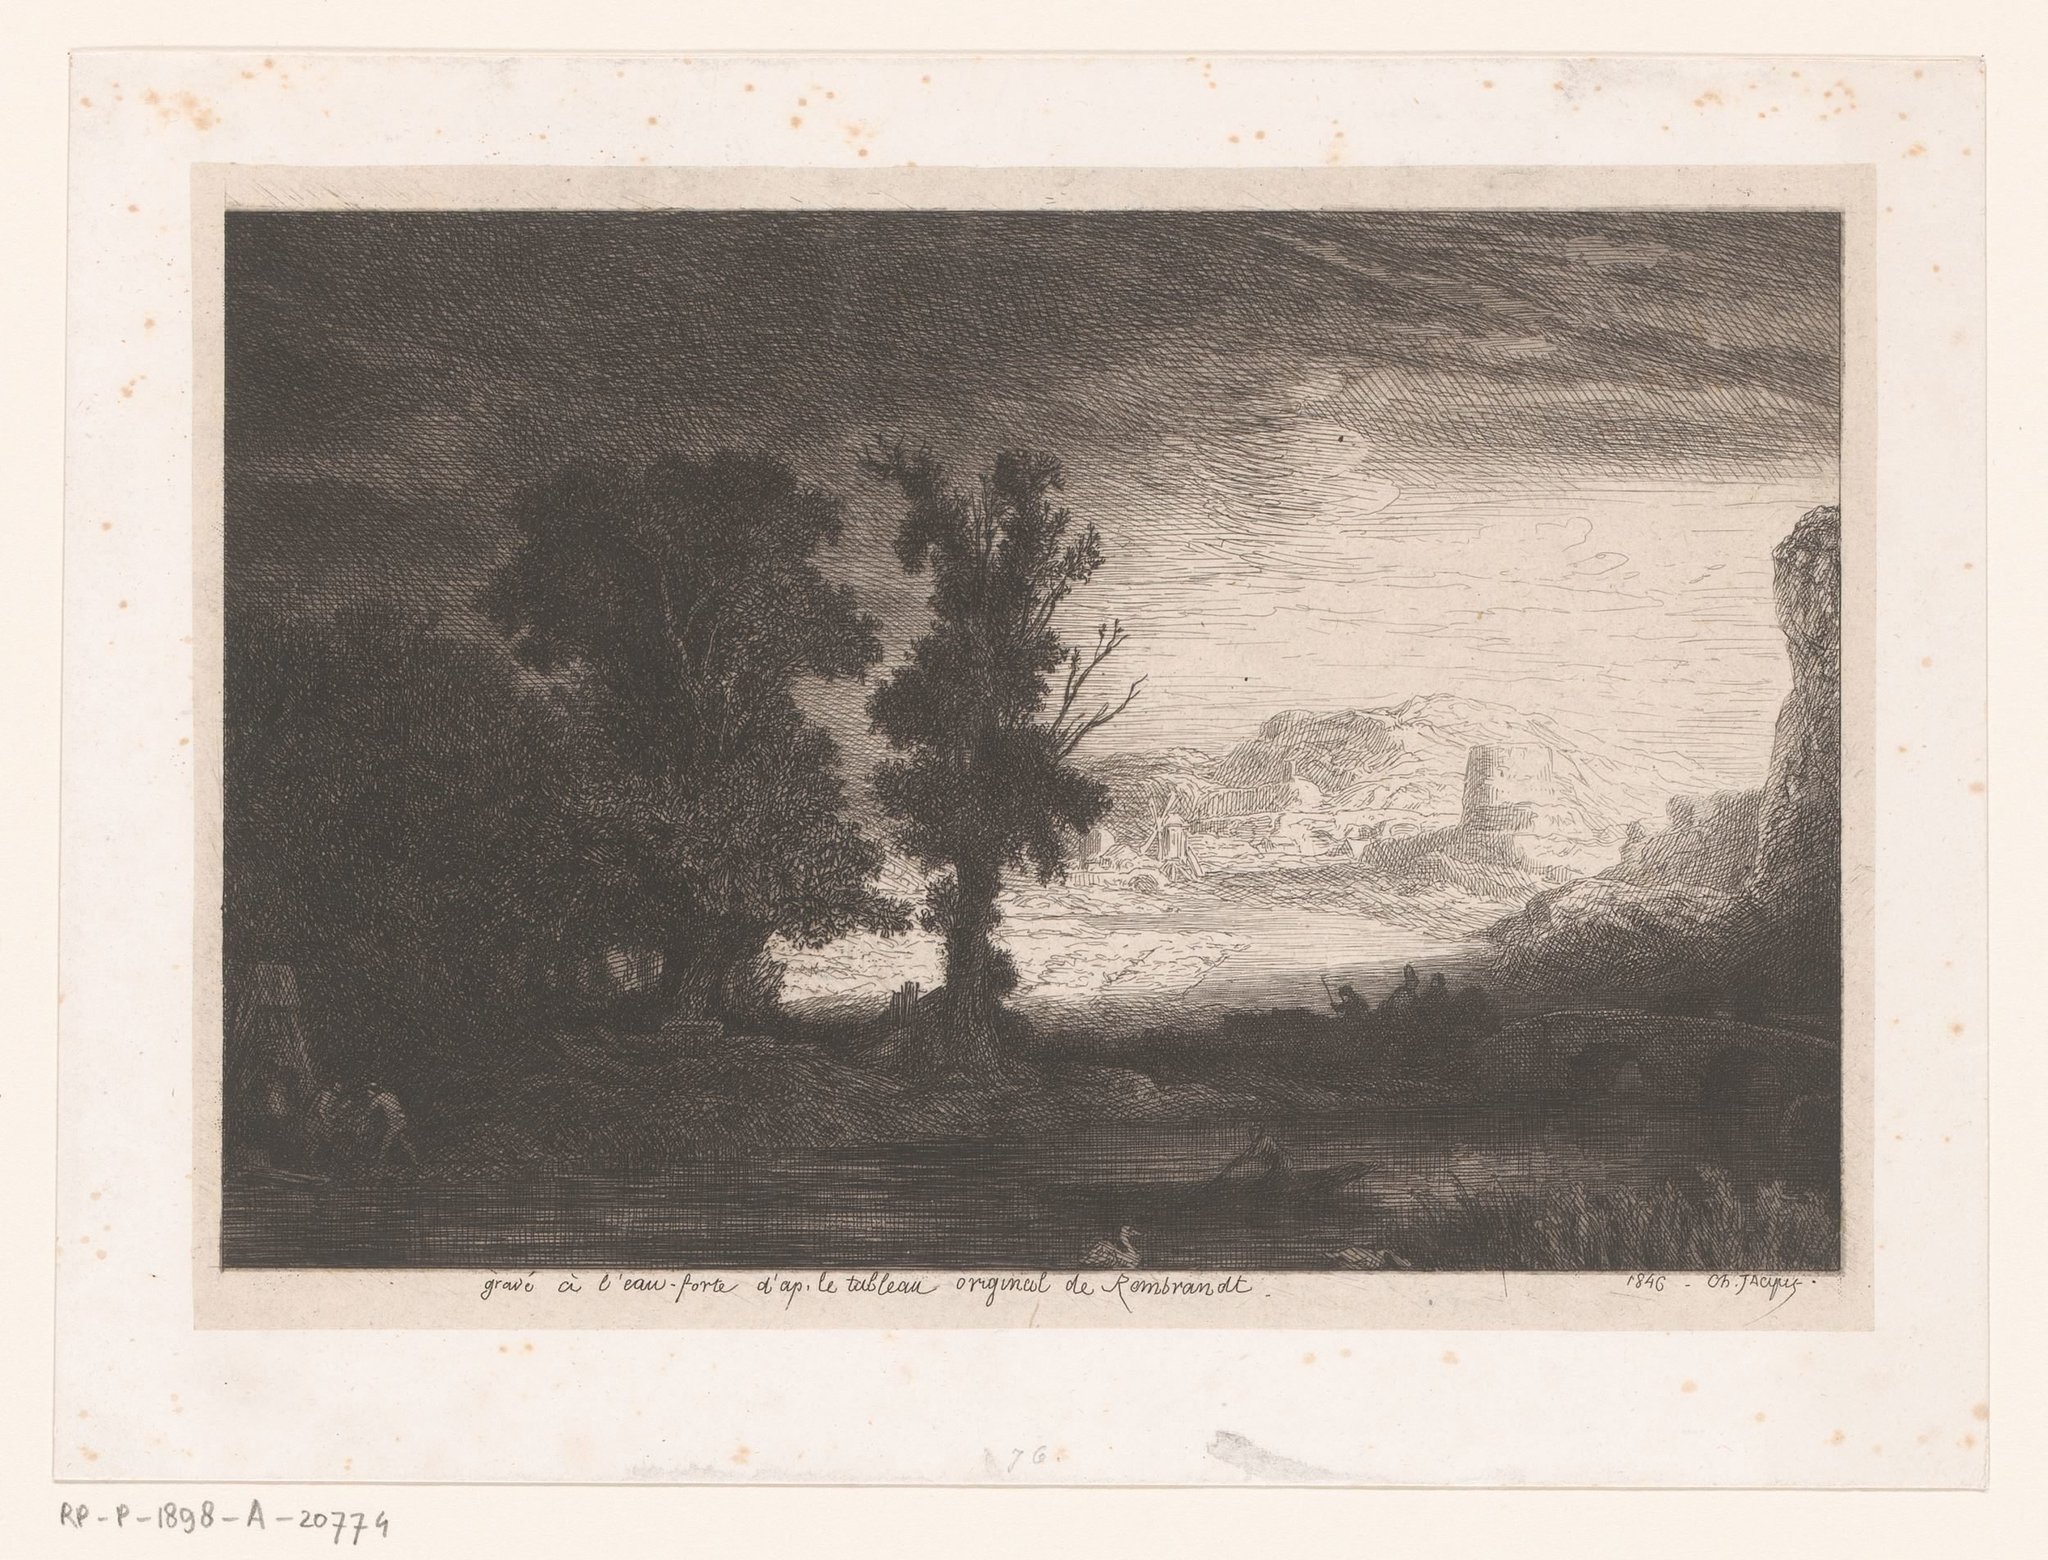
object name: print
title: Rivierlandschap met een brug en bomen, op de achtergrond een molen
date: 1846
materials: paper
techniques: drypoint, engraving, etching, roulette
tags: river, landscape with bridge, viaduct or aqueduct, windmill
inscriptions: collector's mark: Lugt 964